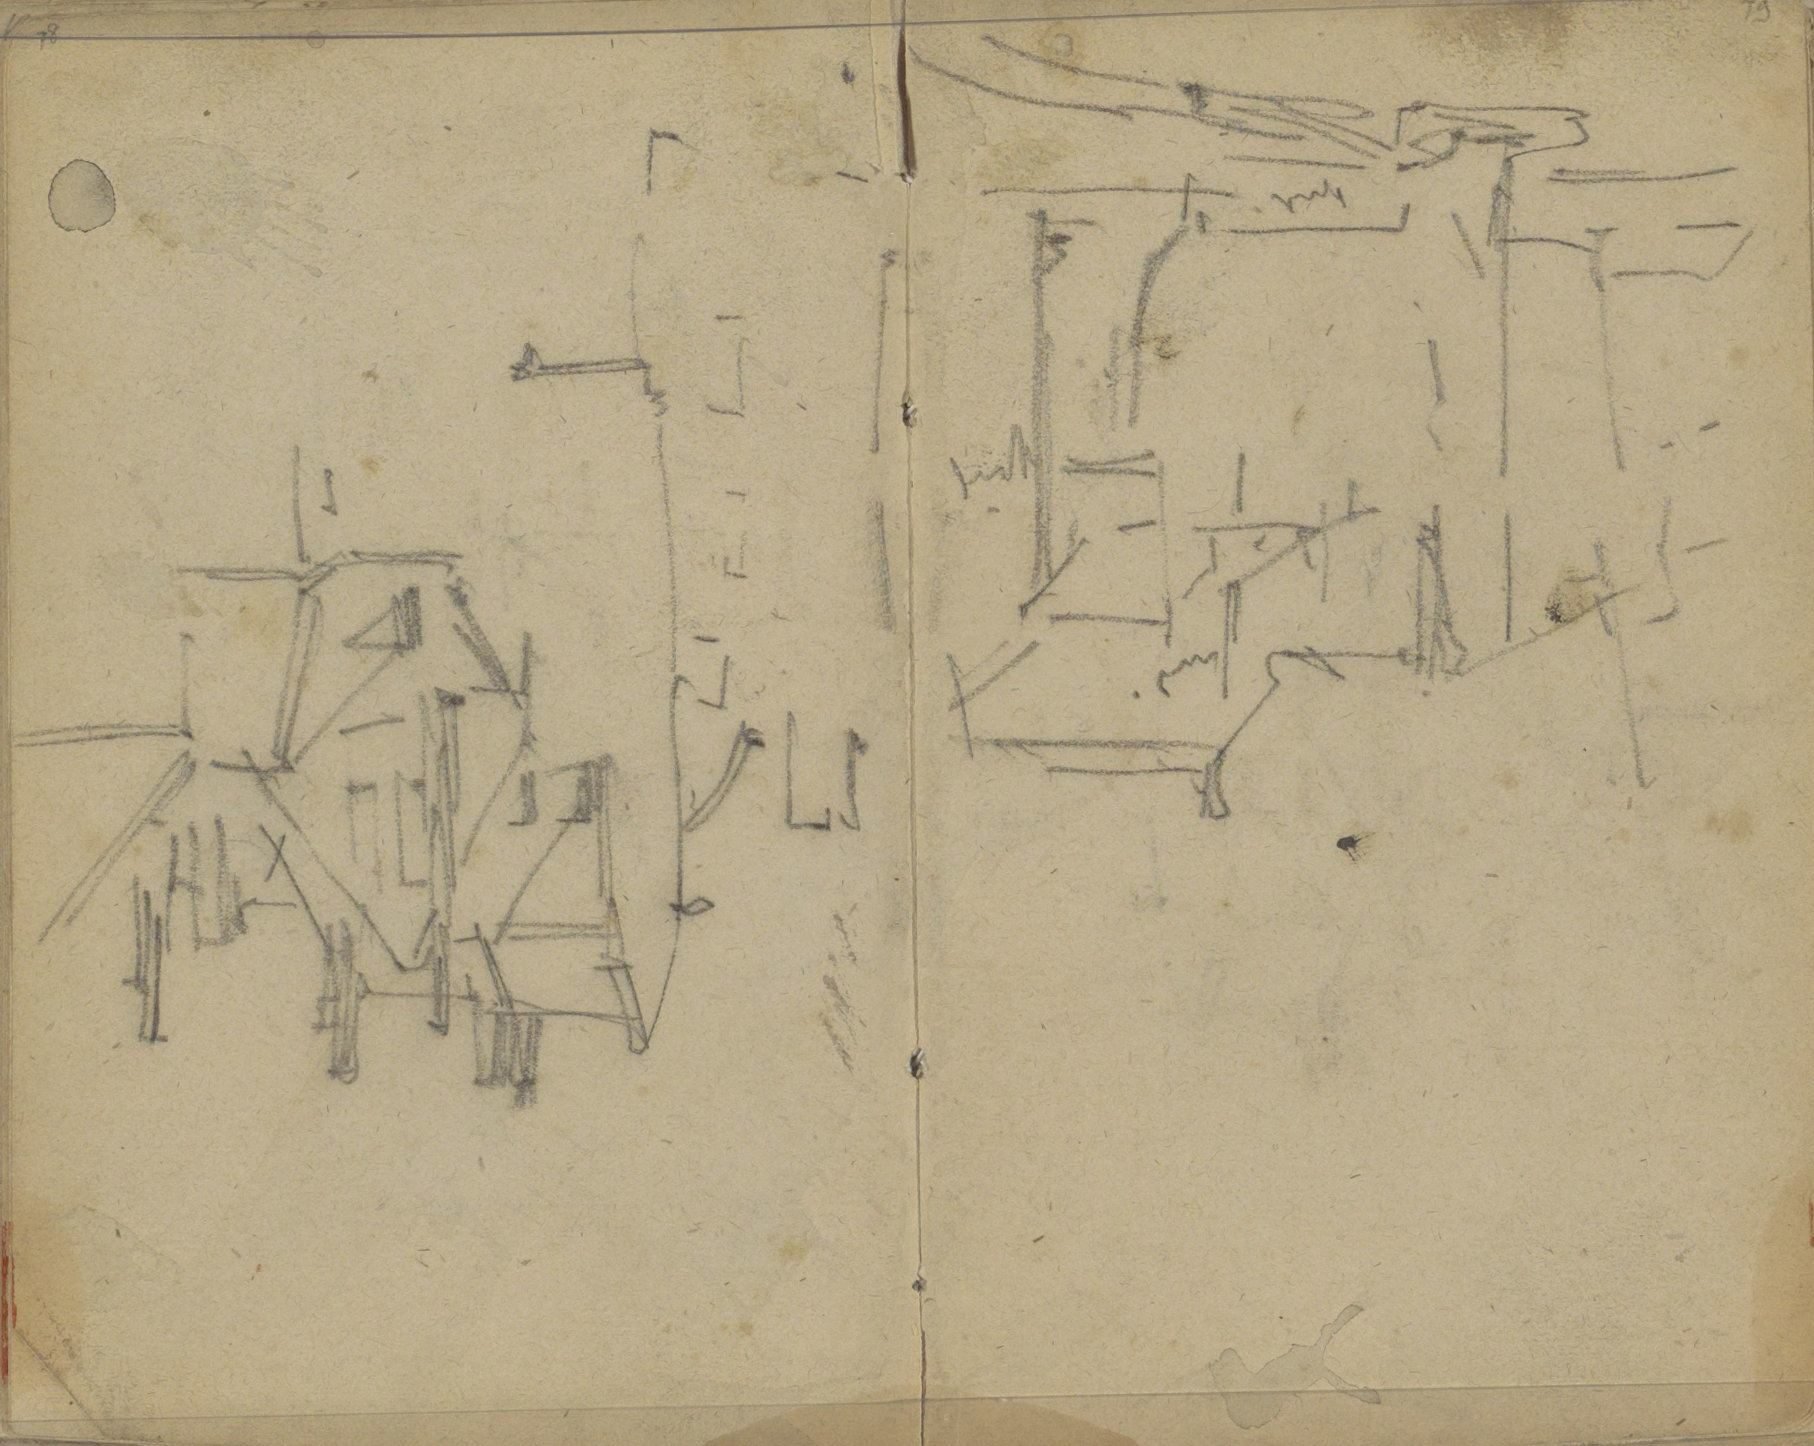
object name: sketchbook leaf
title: Stadsgezicht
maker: george hendrik breitner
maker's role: draughtsman, painter, print maker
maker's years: 1857-1923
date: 1881-1883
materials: chalk, paper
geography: south holland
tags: urban housing, city-view, and landscape with man-made constructions, windmill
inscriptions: kleurnotitie, handgeschreven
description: Stadsgezicht, mogelijk met een molen. Pagina 78 en pagina 79 uit een schetsboek met 70 bladen.